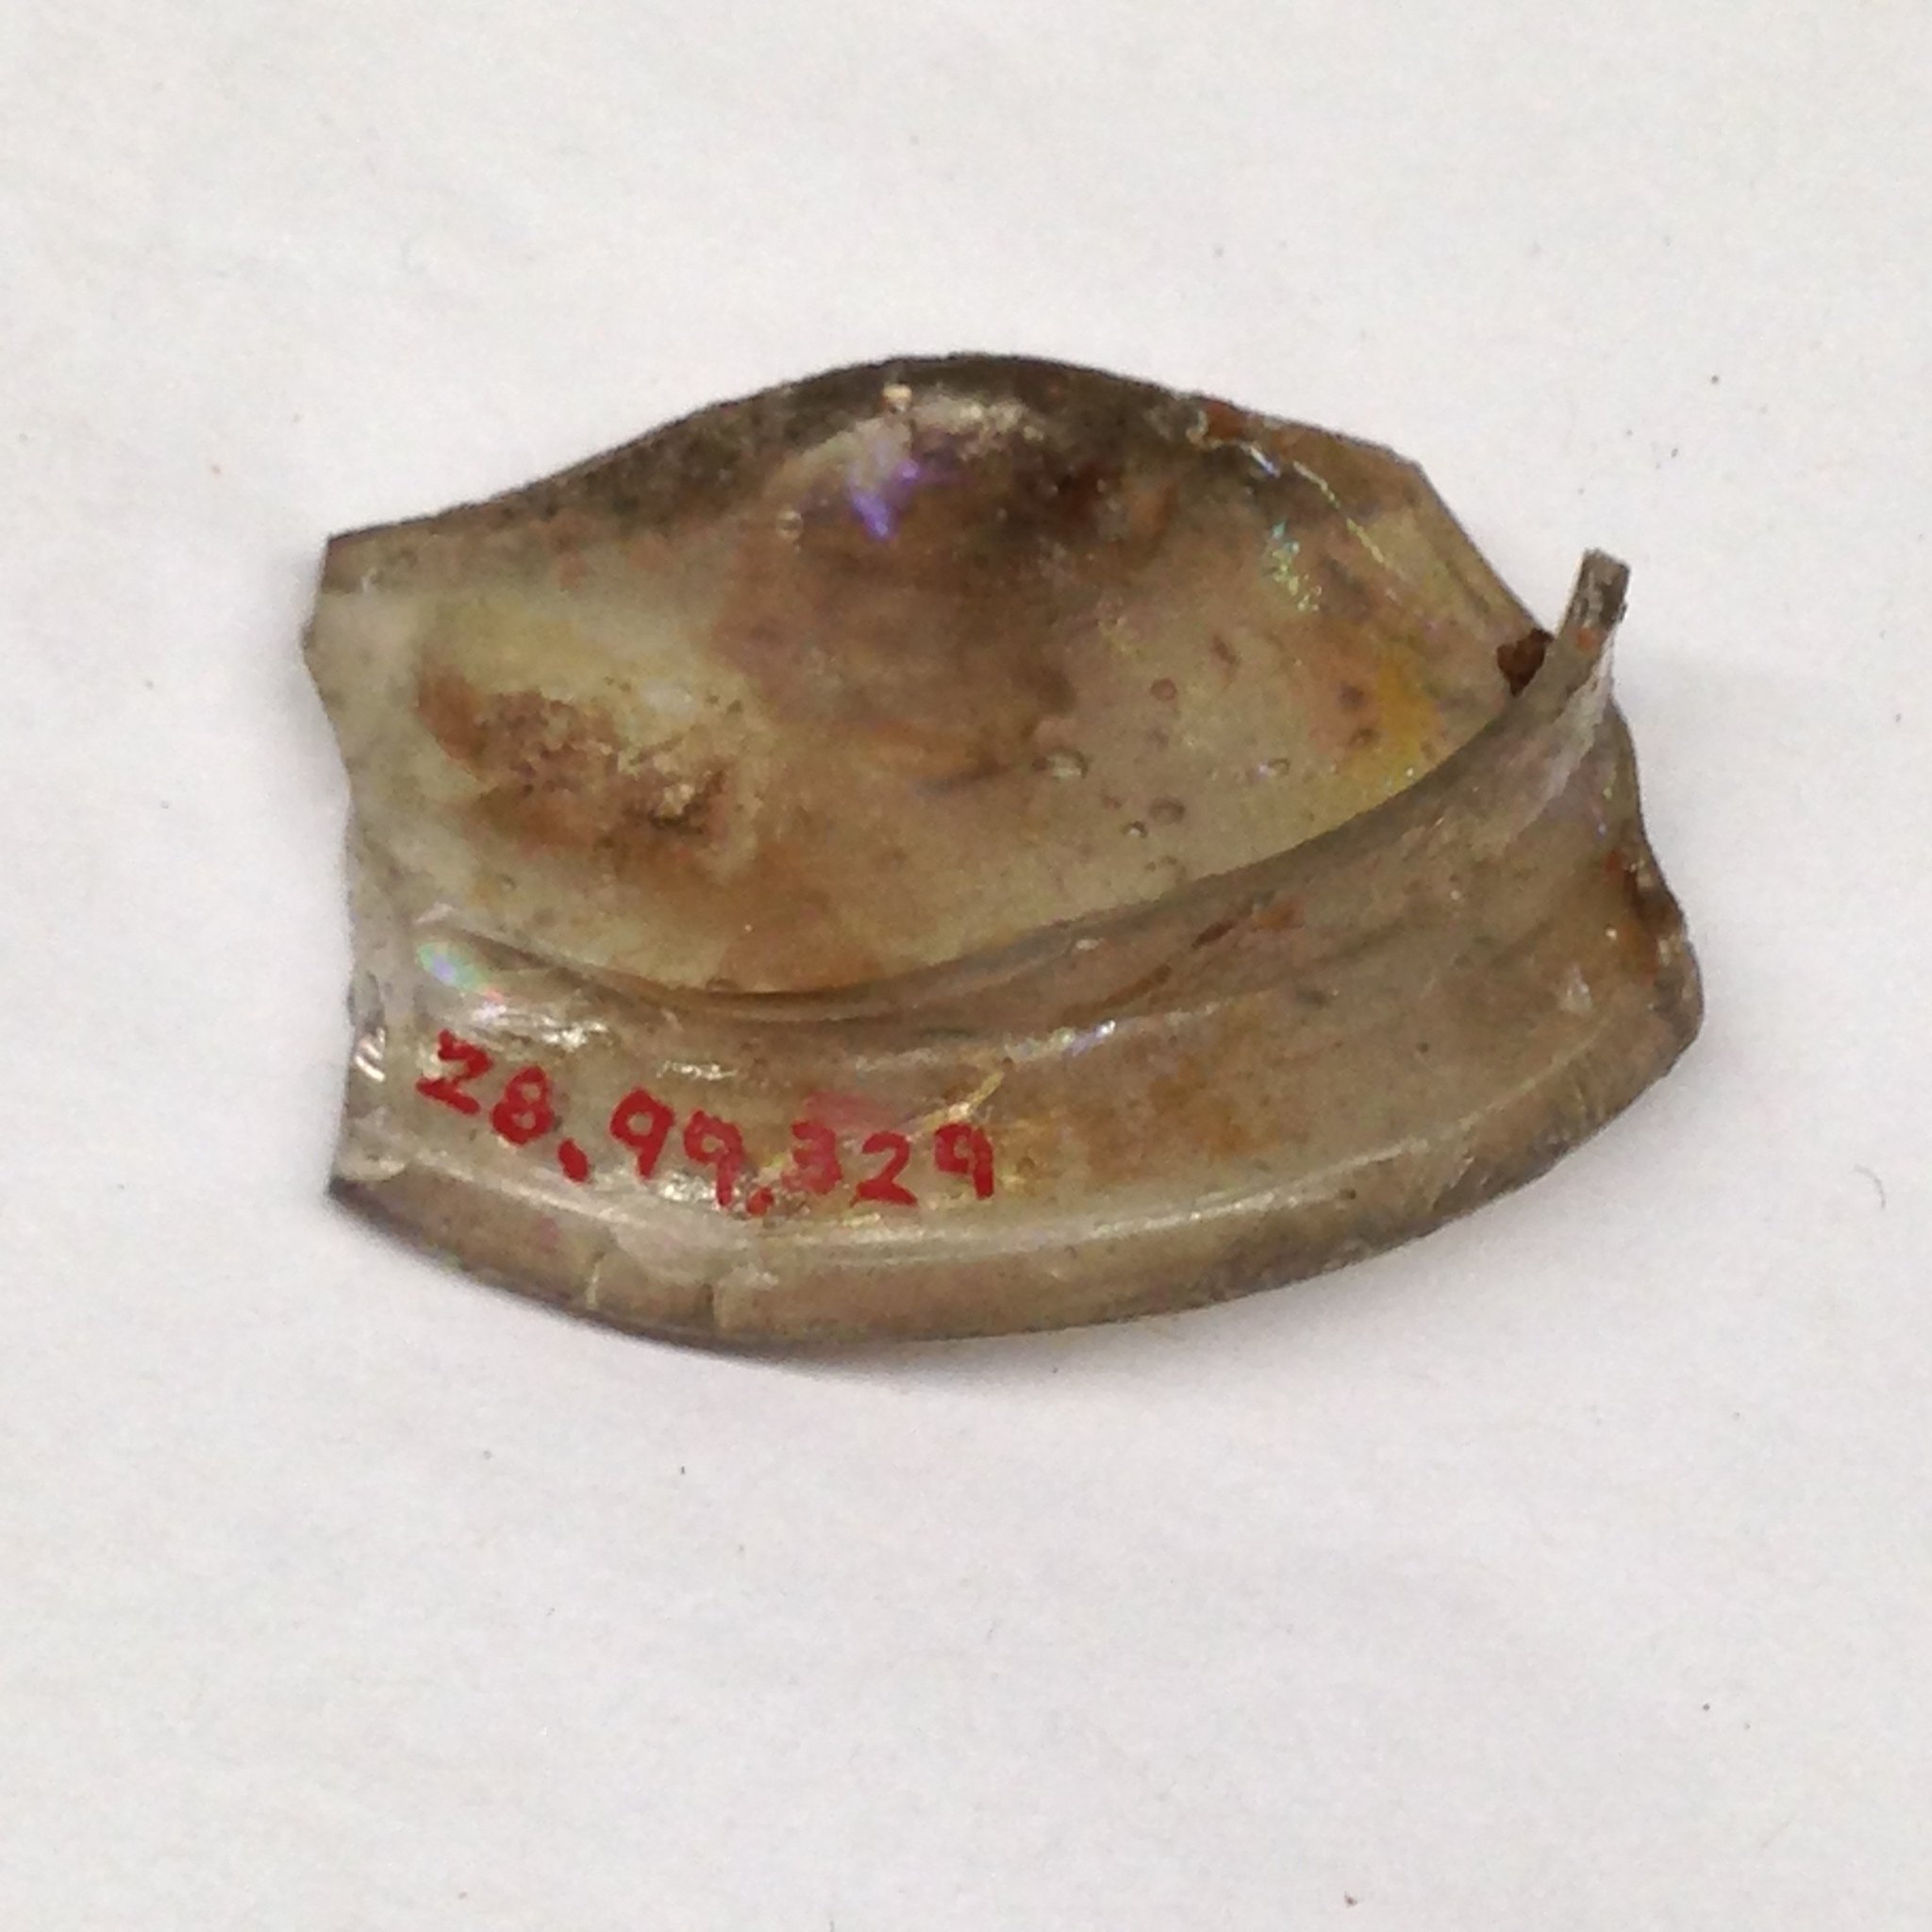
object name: fragment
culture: european or middle eastern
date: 1150-1250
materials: ceramic, glass